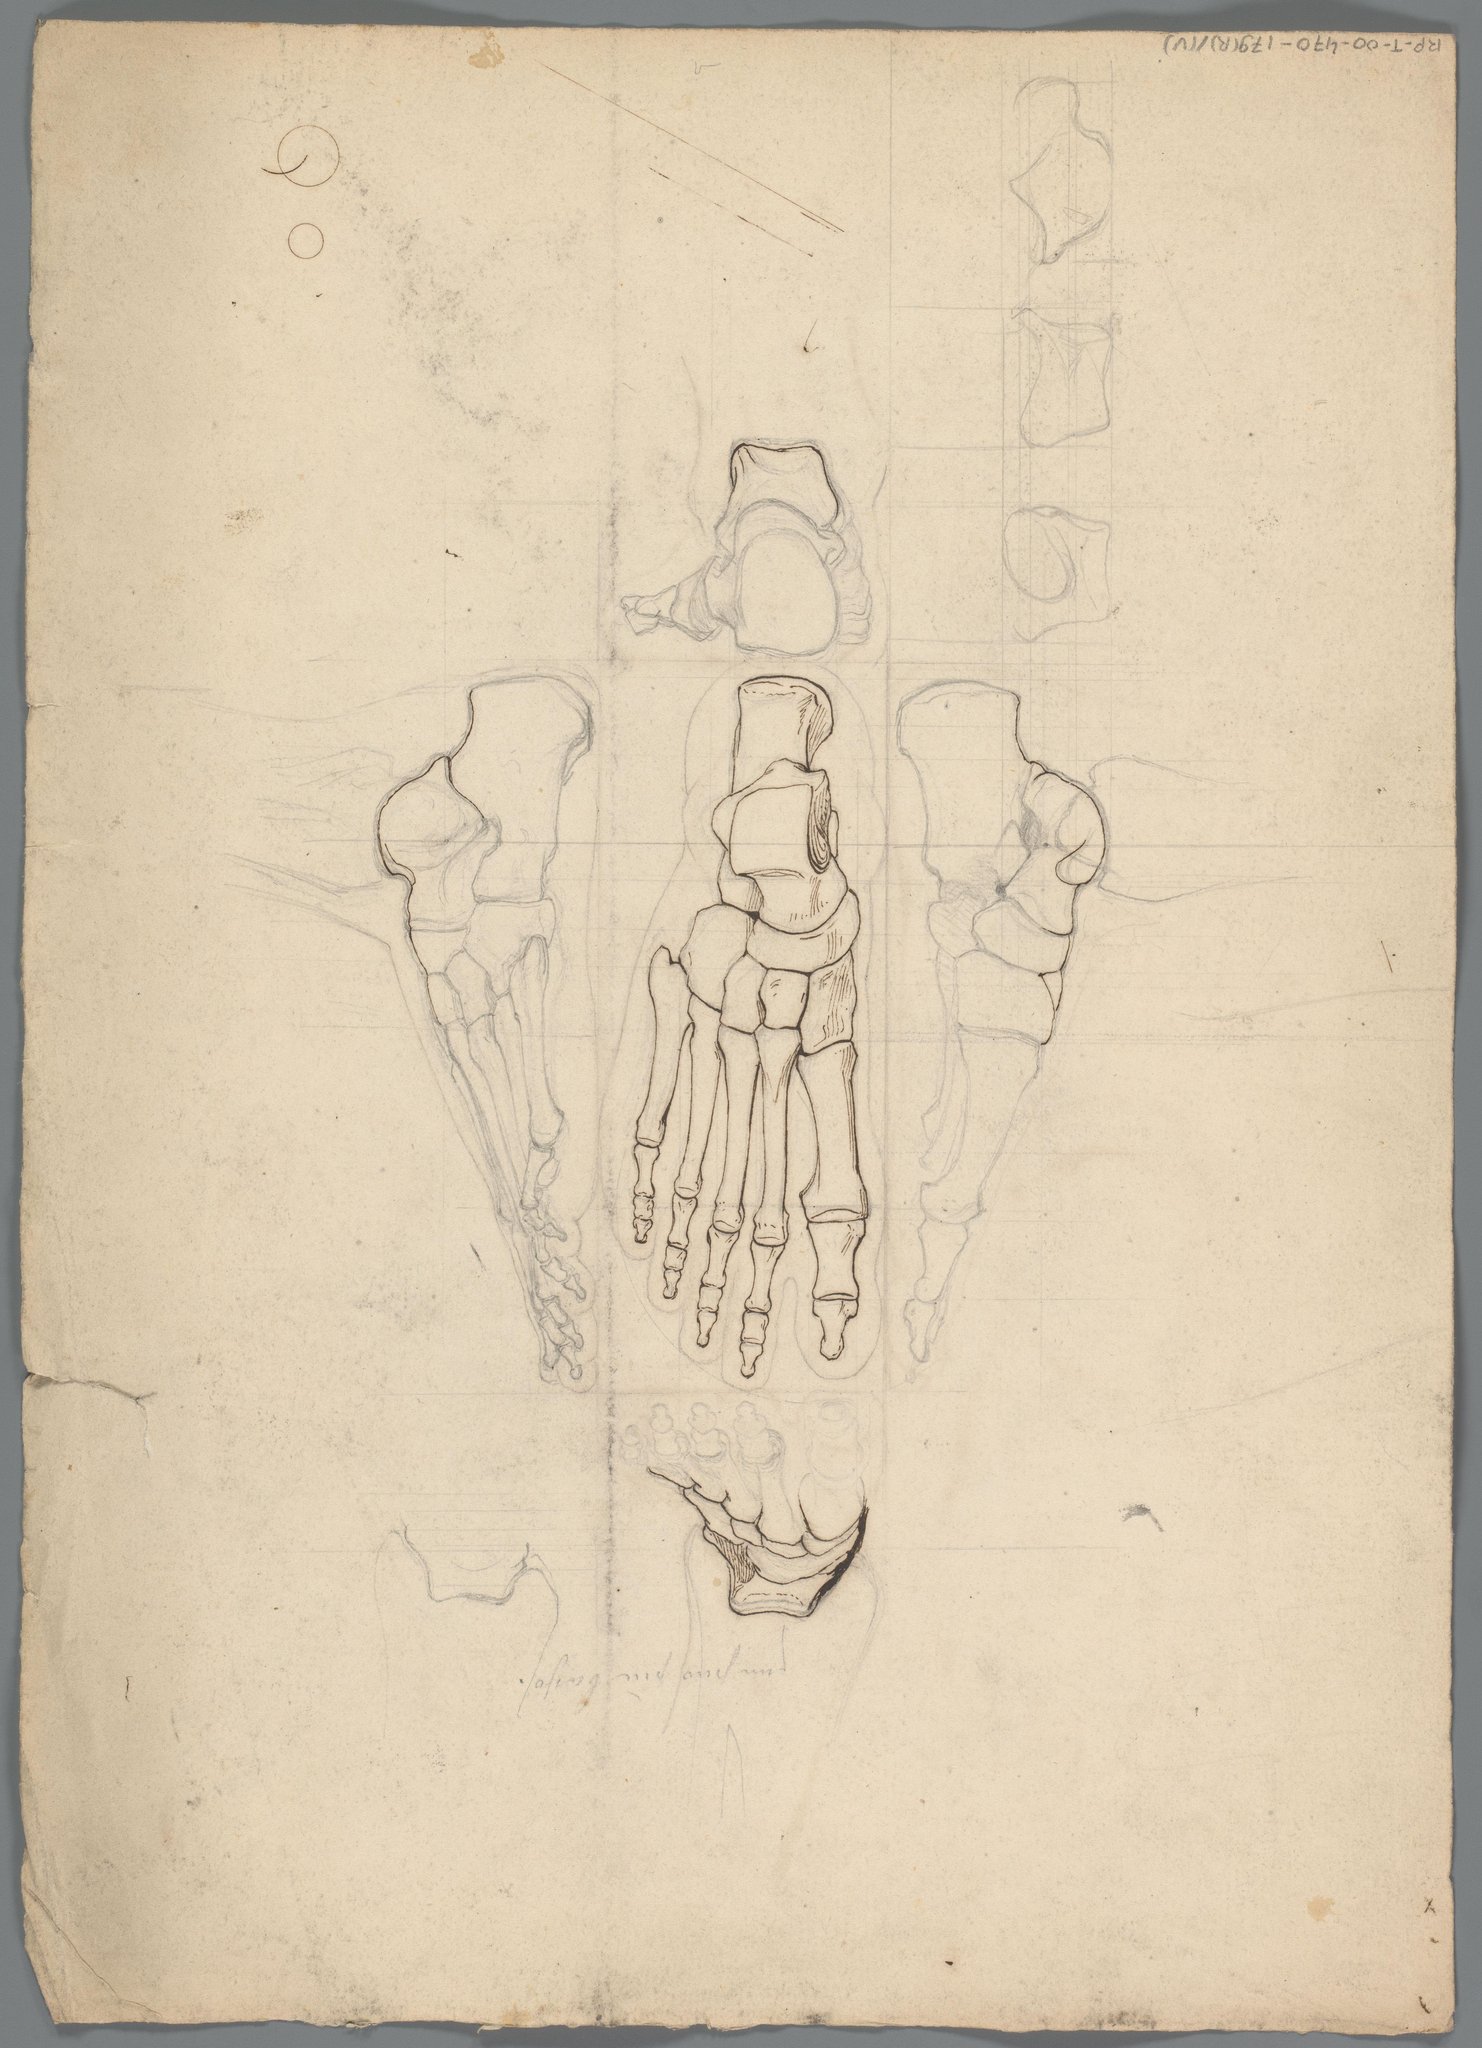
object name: drawing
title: Anatomische studie van het skelet een voet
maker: jacobus everhardus josephus van den berg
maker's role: draughtsman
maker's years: 1802-1861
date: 1812-1861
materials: ink, paper, pencil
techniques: pen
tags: tarsus and metatarsus, parts of the foot